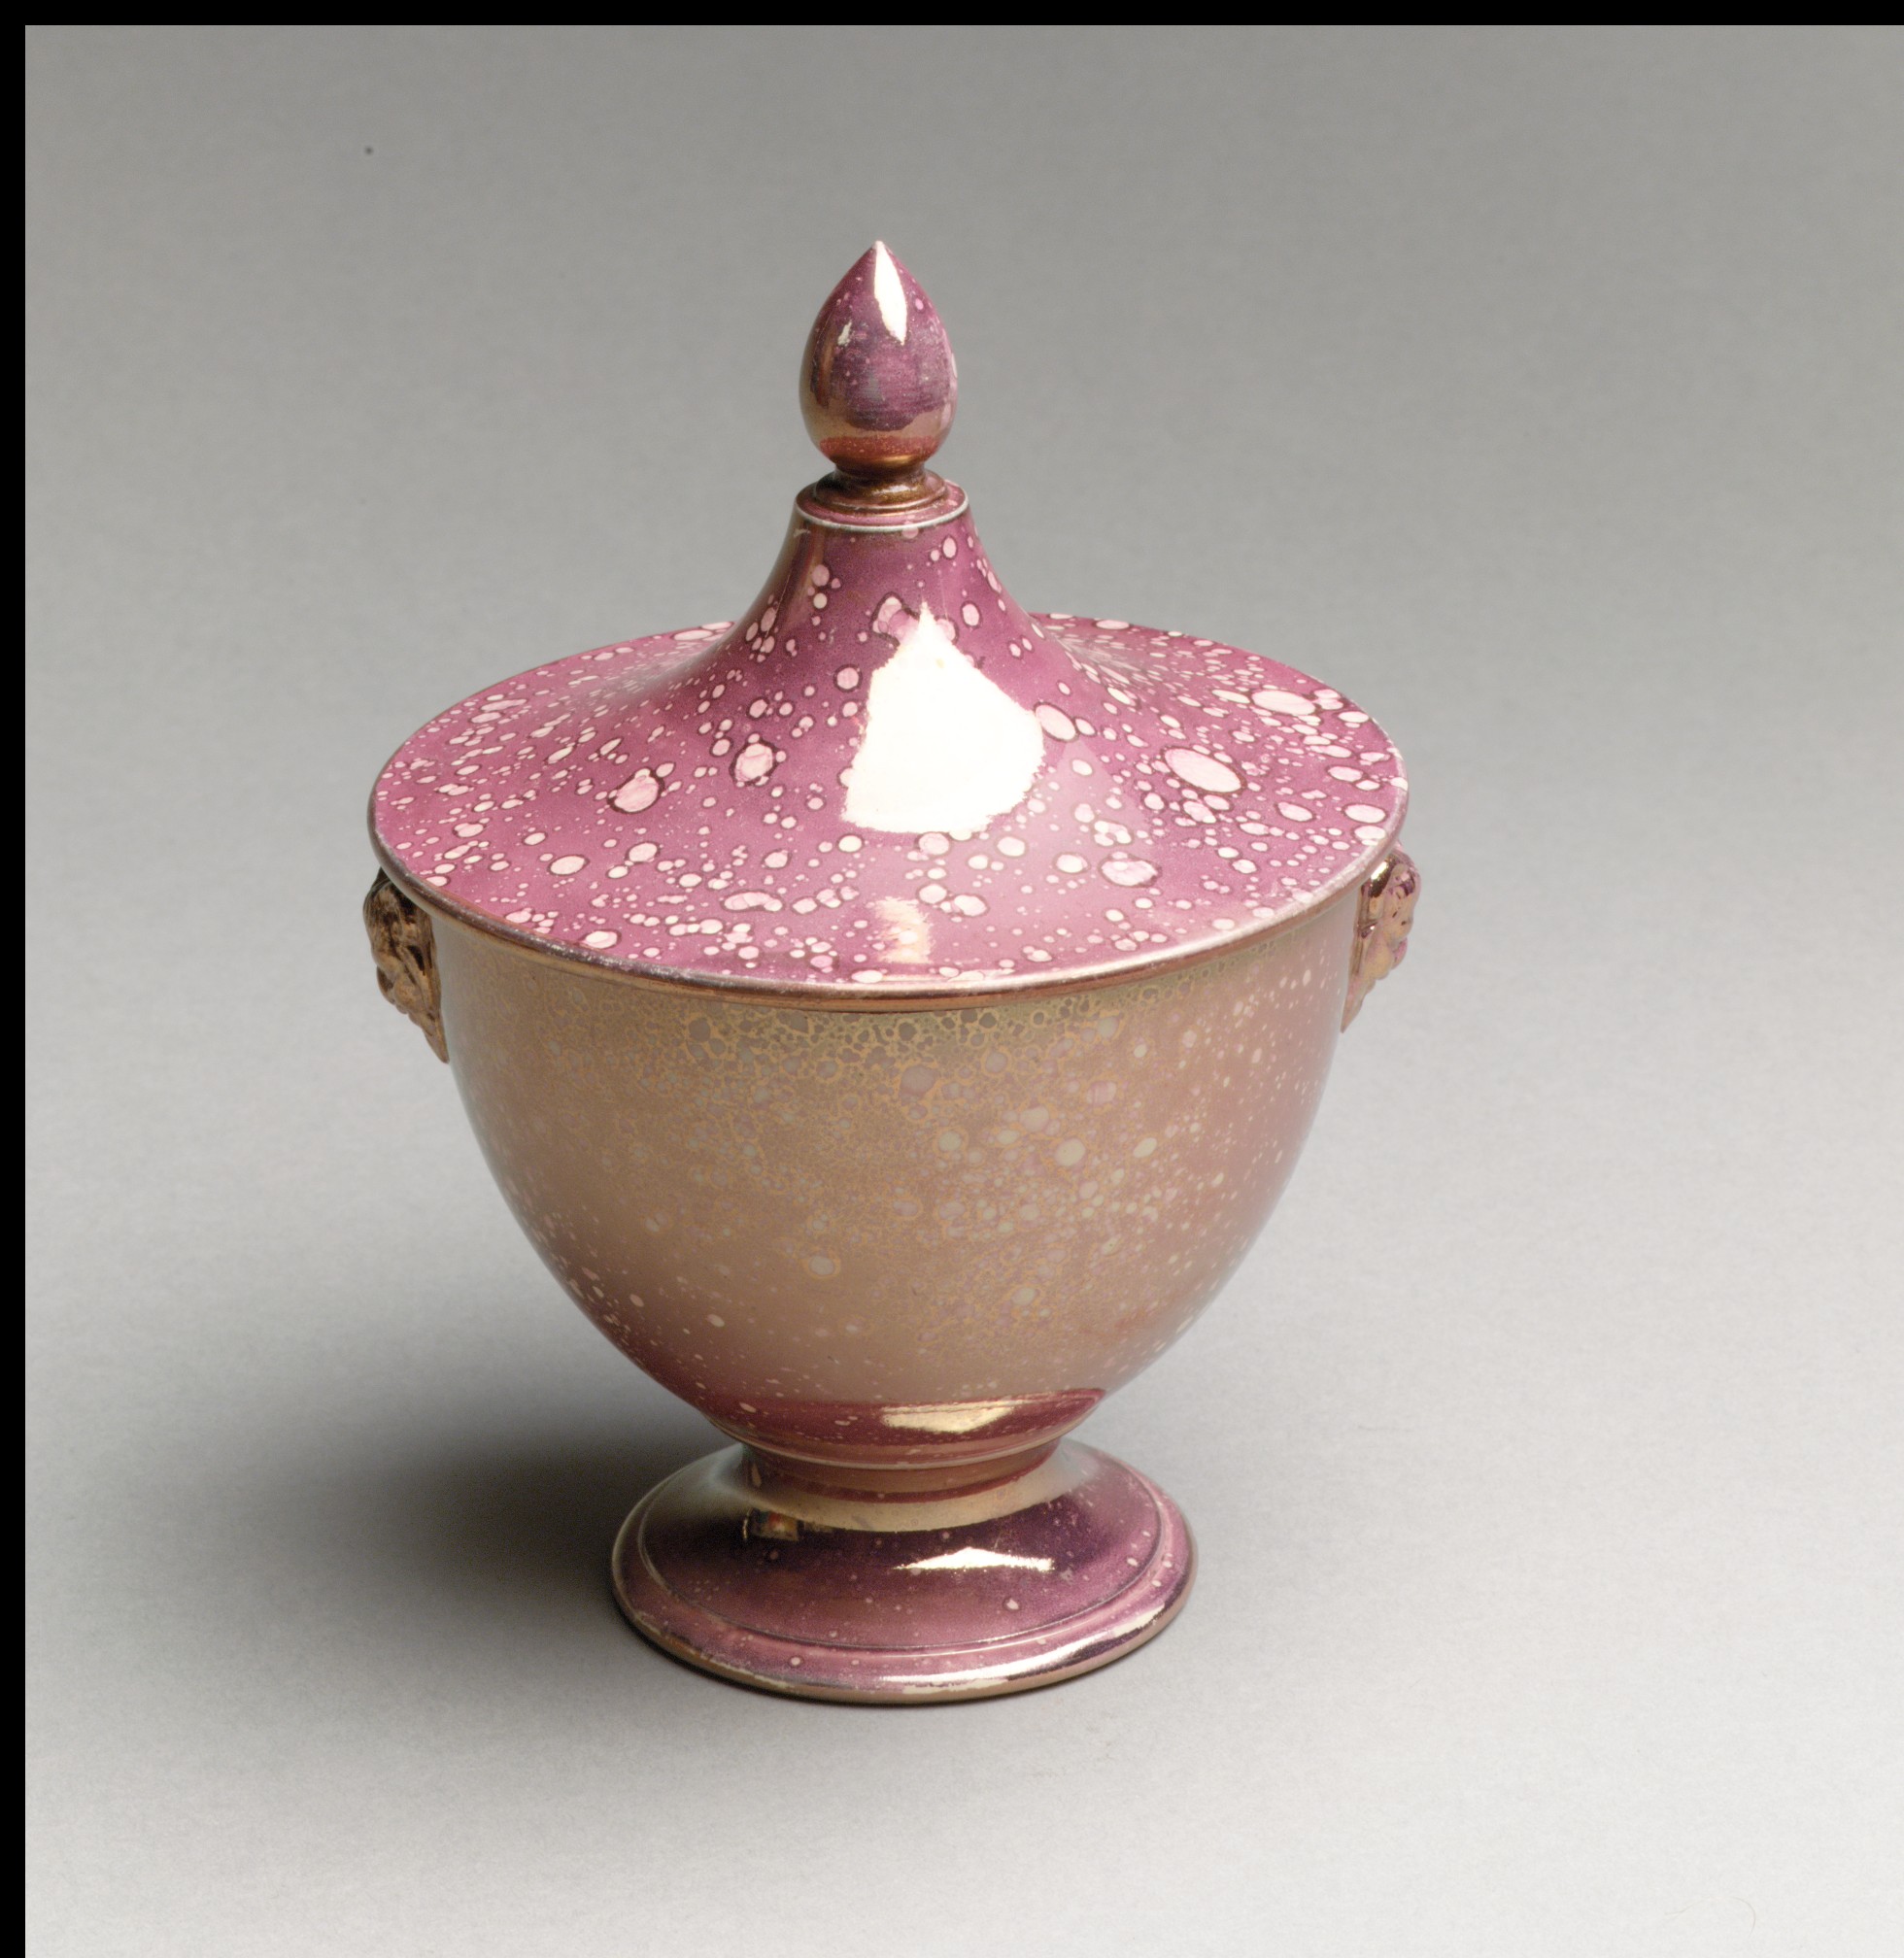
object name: sugar with cover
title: Sugar with cover (part of a set)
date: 1810